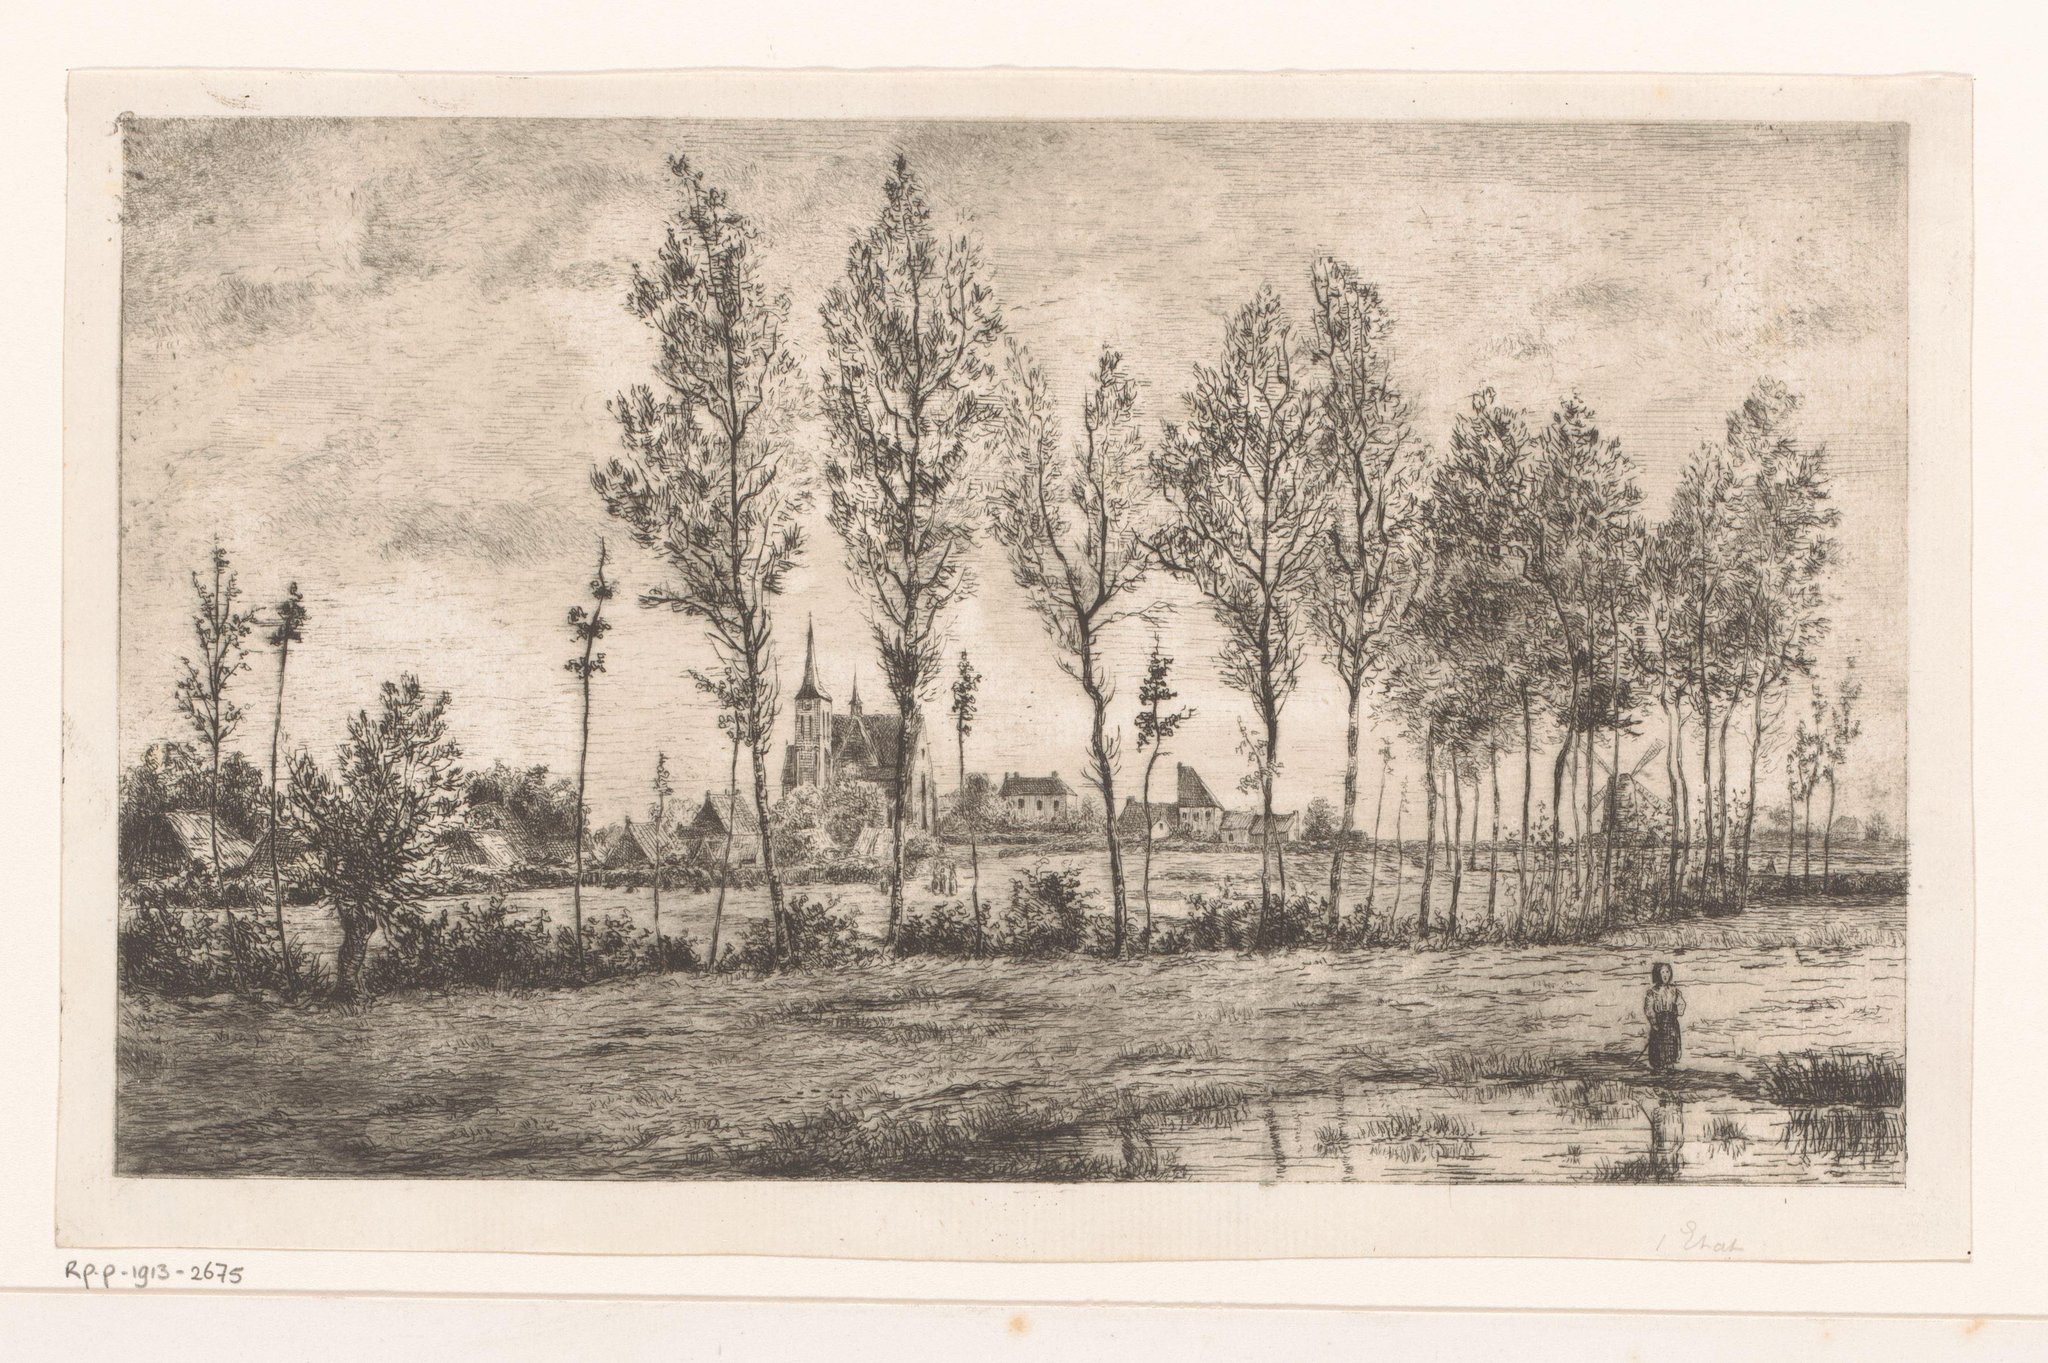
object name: print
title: Gezicht op Meerle met bomenrij en water op de voorgrond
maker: emilie rolin-jacquemijns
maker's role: print maker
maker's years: 1842-1906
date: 1873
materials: paper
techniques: etching, intaglio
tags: village, church (exterior), water course (+ landscape with figures, staffage)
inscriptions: collector's mark: Lugt 2228